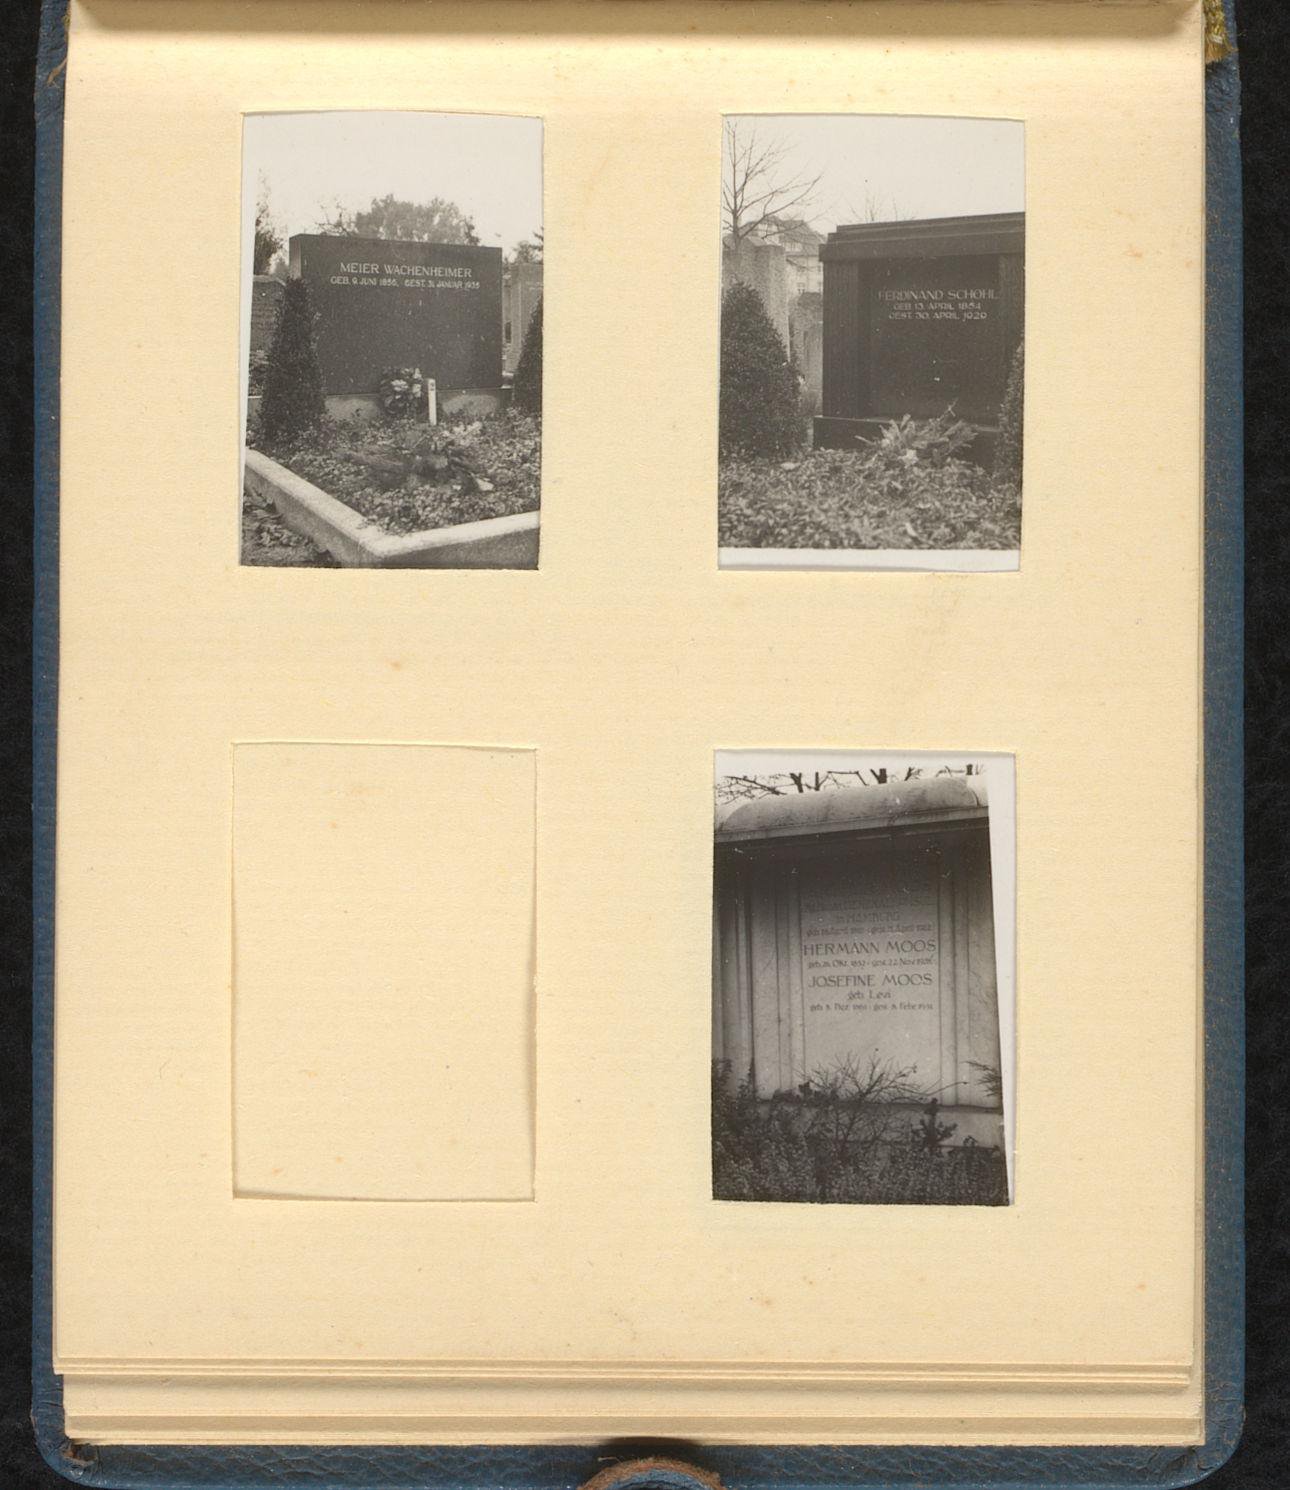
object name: photograph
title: Graven van Meir Wachenheimer, Ferdinand Schohl, Hermann Moos en Josefine Moos-Levi, 1937, Stuttgart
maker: else wachenheimer-moos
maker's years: 1895-1944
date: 1937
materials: paper, photographic support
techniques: gelatin silver print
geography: stuttgart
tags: grave, tomb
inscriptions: date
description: Albumblad bevat drie foto's. Zonder personen gerelateerd aan de familie Wachenheimer. Uit klein formaat fotoalbum, blauw lederen omslag met drukknopsluiting. Met foto's in klein formaat.